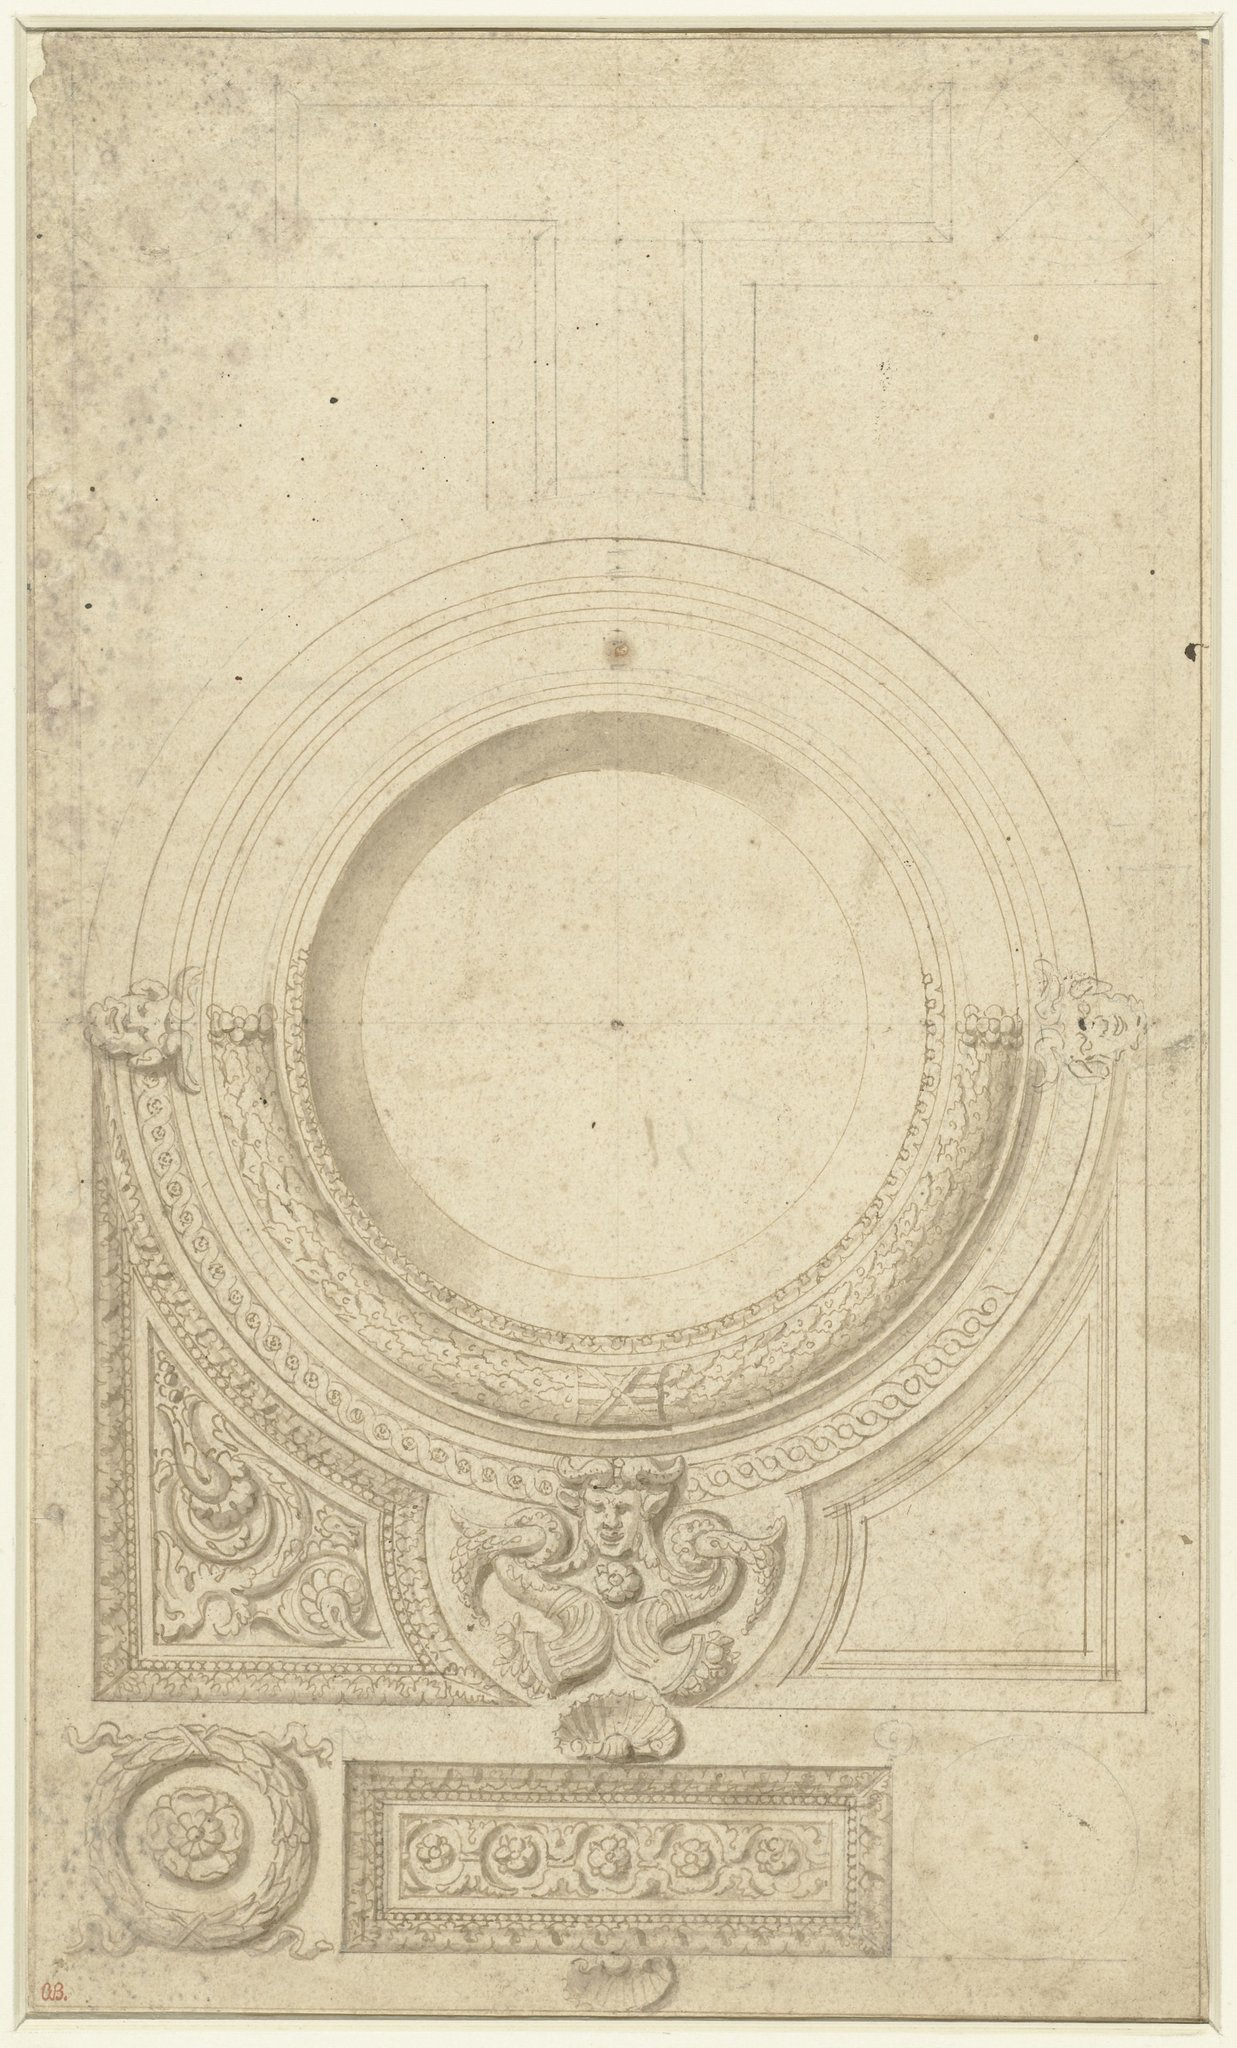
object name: drawing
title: Ontwerp voor een plafond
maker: Anonymous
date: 1600-1699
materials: ink, paper, pencil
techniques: brush, pen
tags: (decorated) ceiling